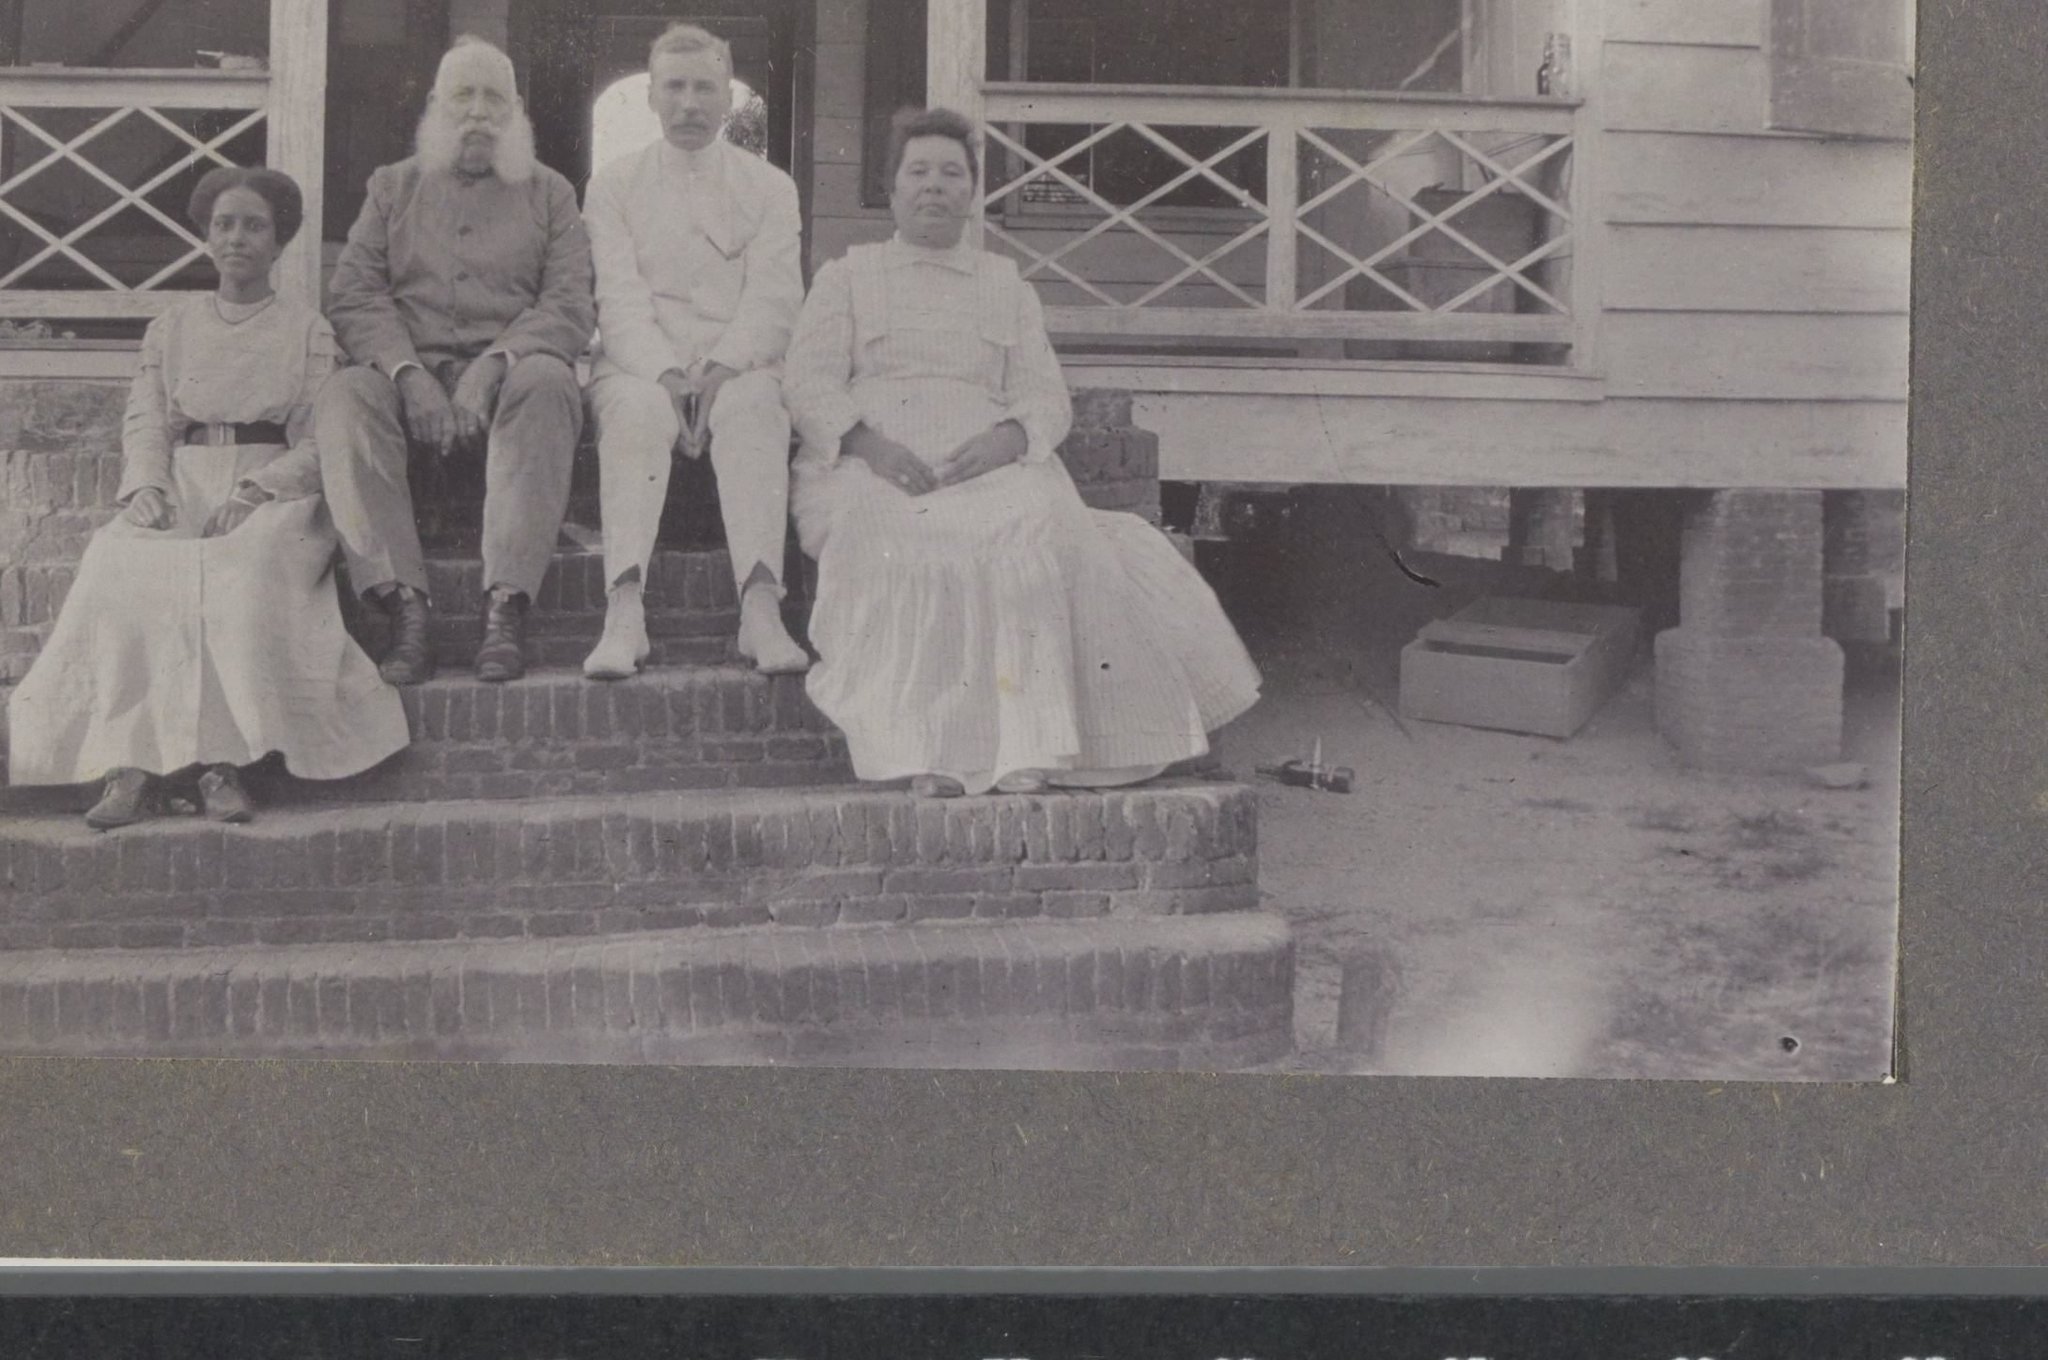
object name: photograph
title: Plantage Caledonia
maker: Anonymous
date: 1911-1912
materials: photographic support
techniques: photography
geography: suriname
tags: amsterdam, andries augustus boom, plantation, suriname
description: Andries Boom zittend met drie anderen op de trap van het huis op Plantage Caledonia, ca. 1911-1912. Onderdeel van het fotoalbum over het leven van de familie Gonggrijp in Suriname rond 1912.